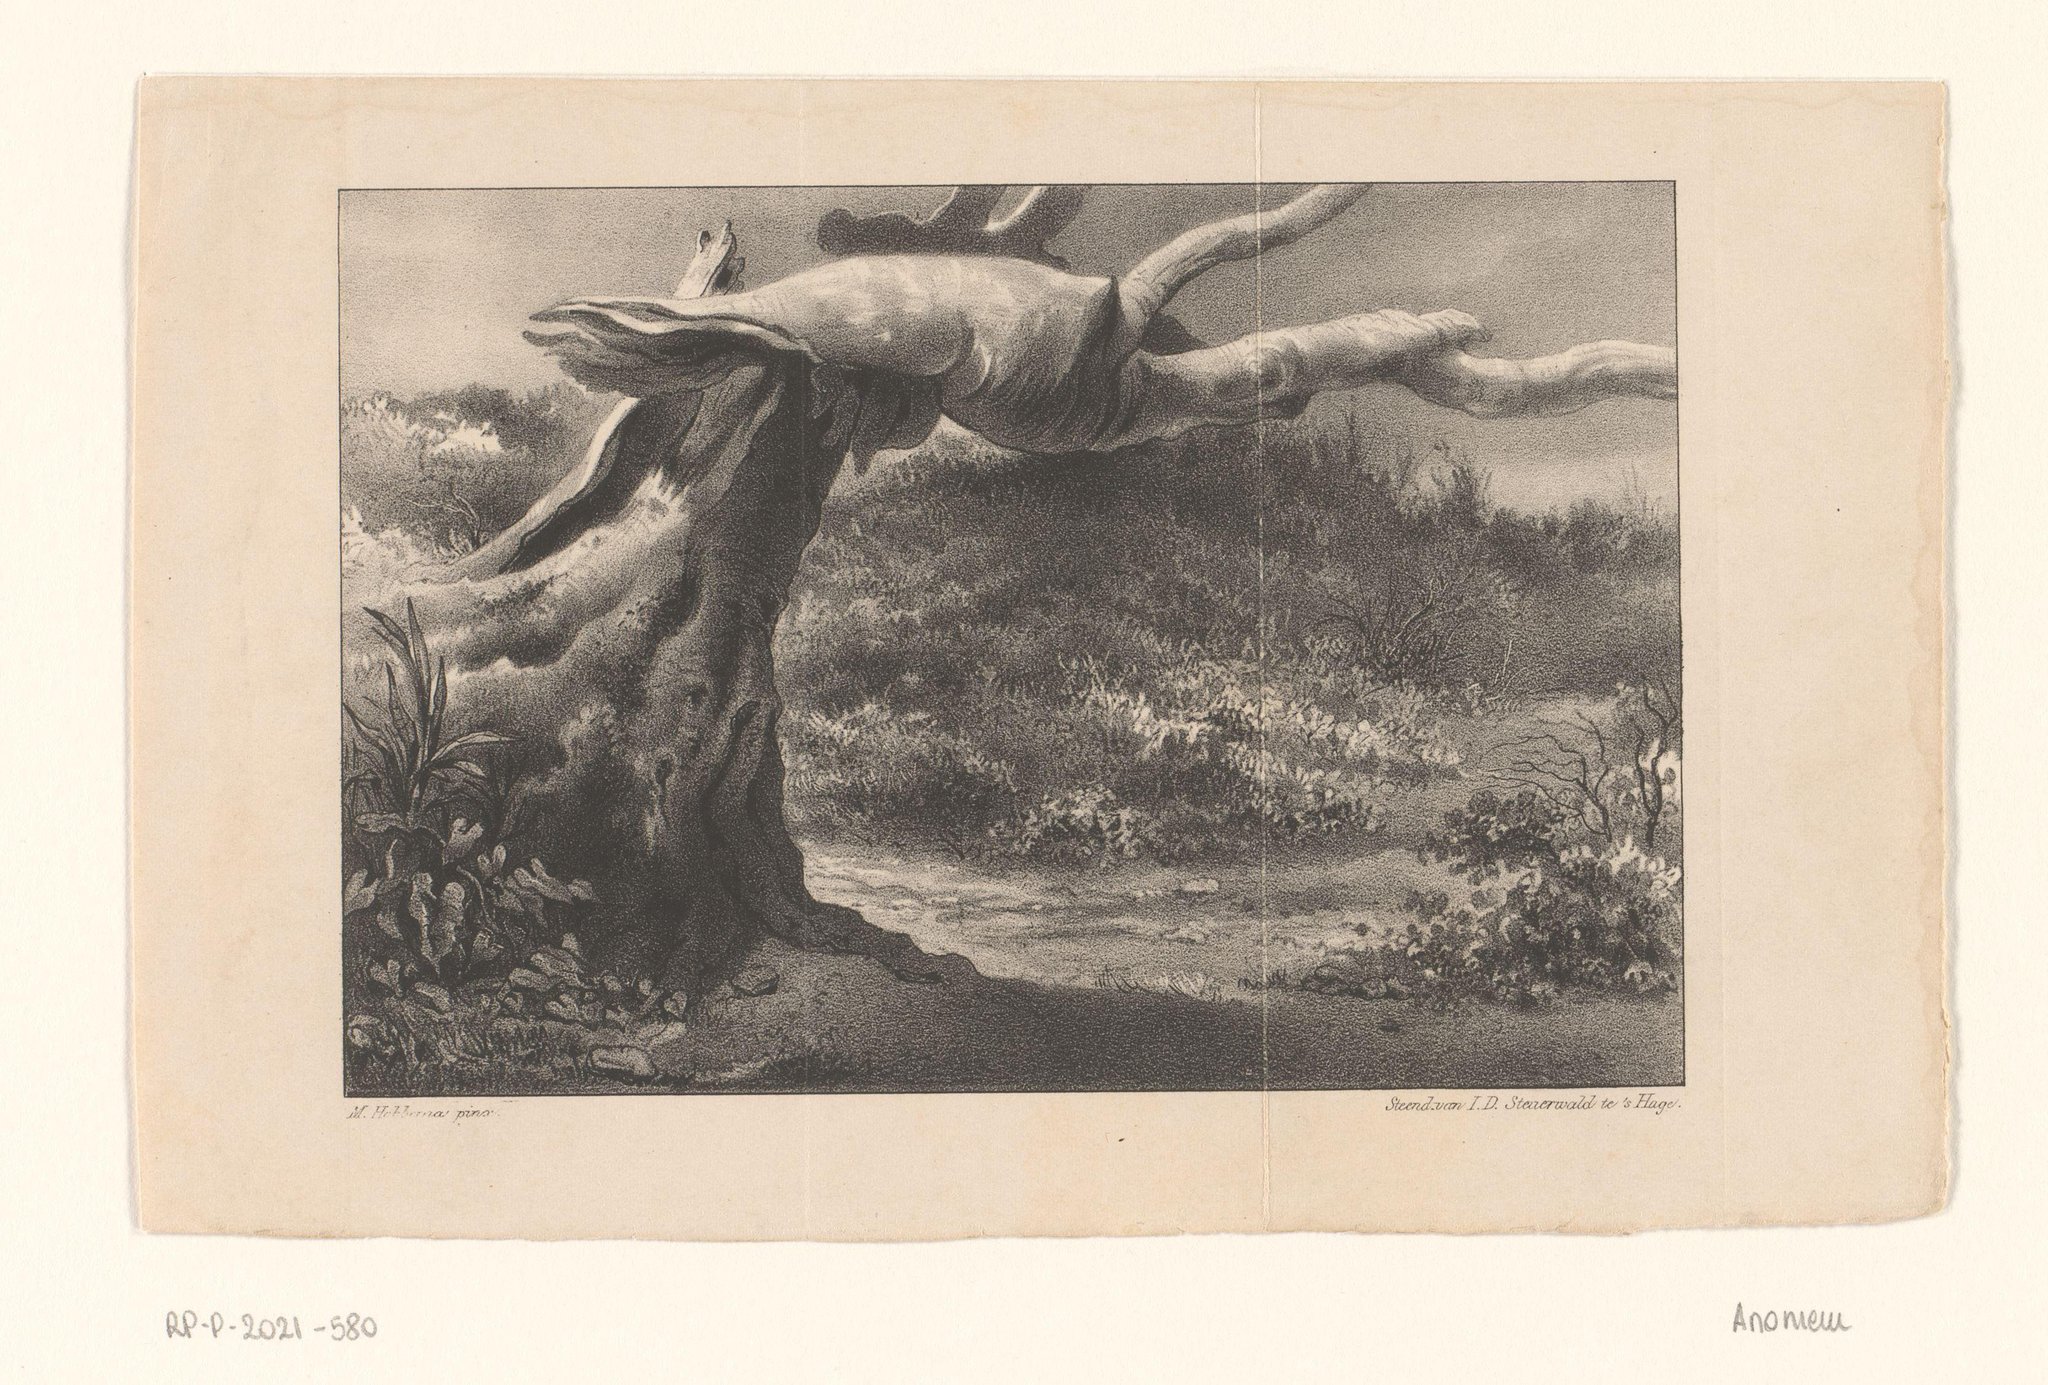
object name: print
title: Pad met overhangende gebroken boomstam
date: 1840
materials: paper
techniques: lithograph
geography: netherlands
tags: trees (with name) (+ stem, trunk), road, path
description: Prent waarschijnlijk uit: Drentsche volksalmanak, 1840.